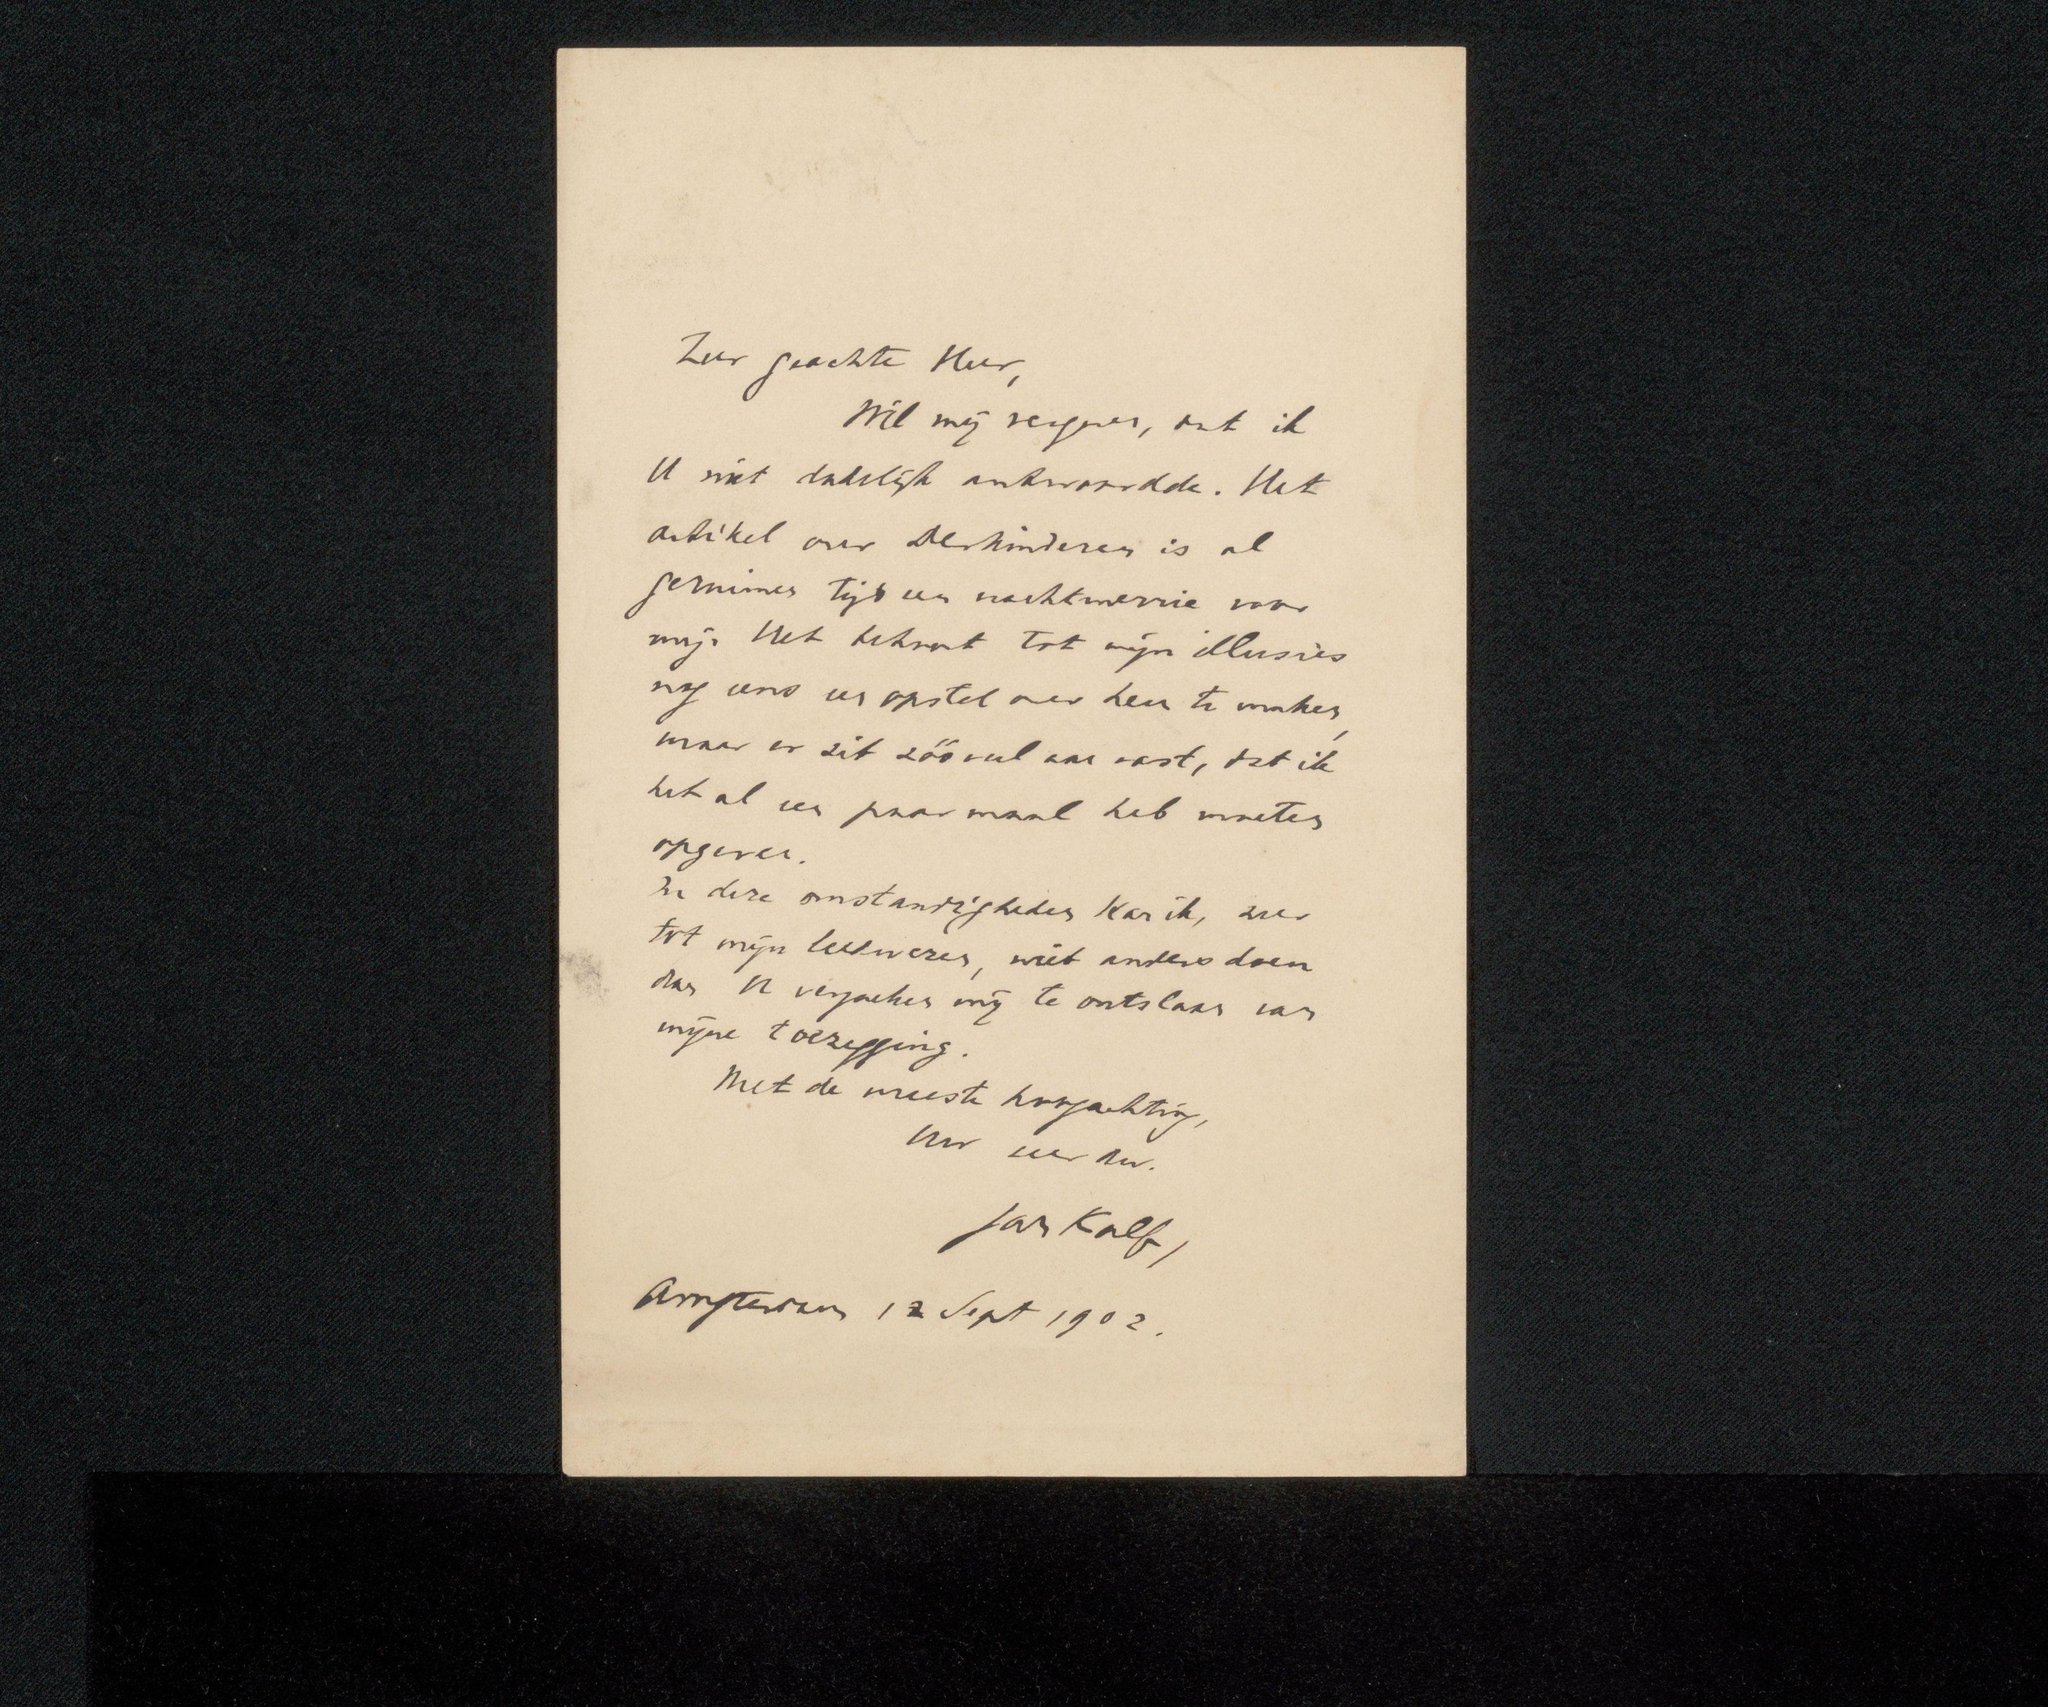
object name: letter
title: Brief aan Philip Zilcken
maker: jan kalf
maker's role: directeur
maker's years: 1873-1954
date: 1902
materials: ink, paper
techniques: pen, writing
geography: amsterdam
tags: den bosch, print maker, antoon derkinderen, the hague, painter, draughtsman, philip zilcken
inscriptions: collector's mark: ‘RPK’